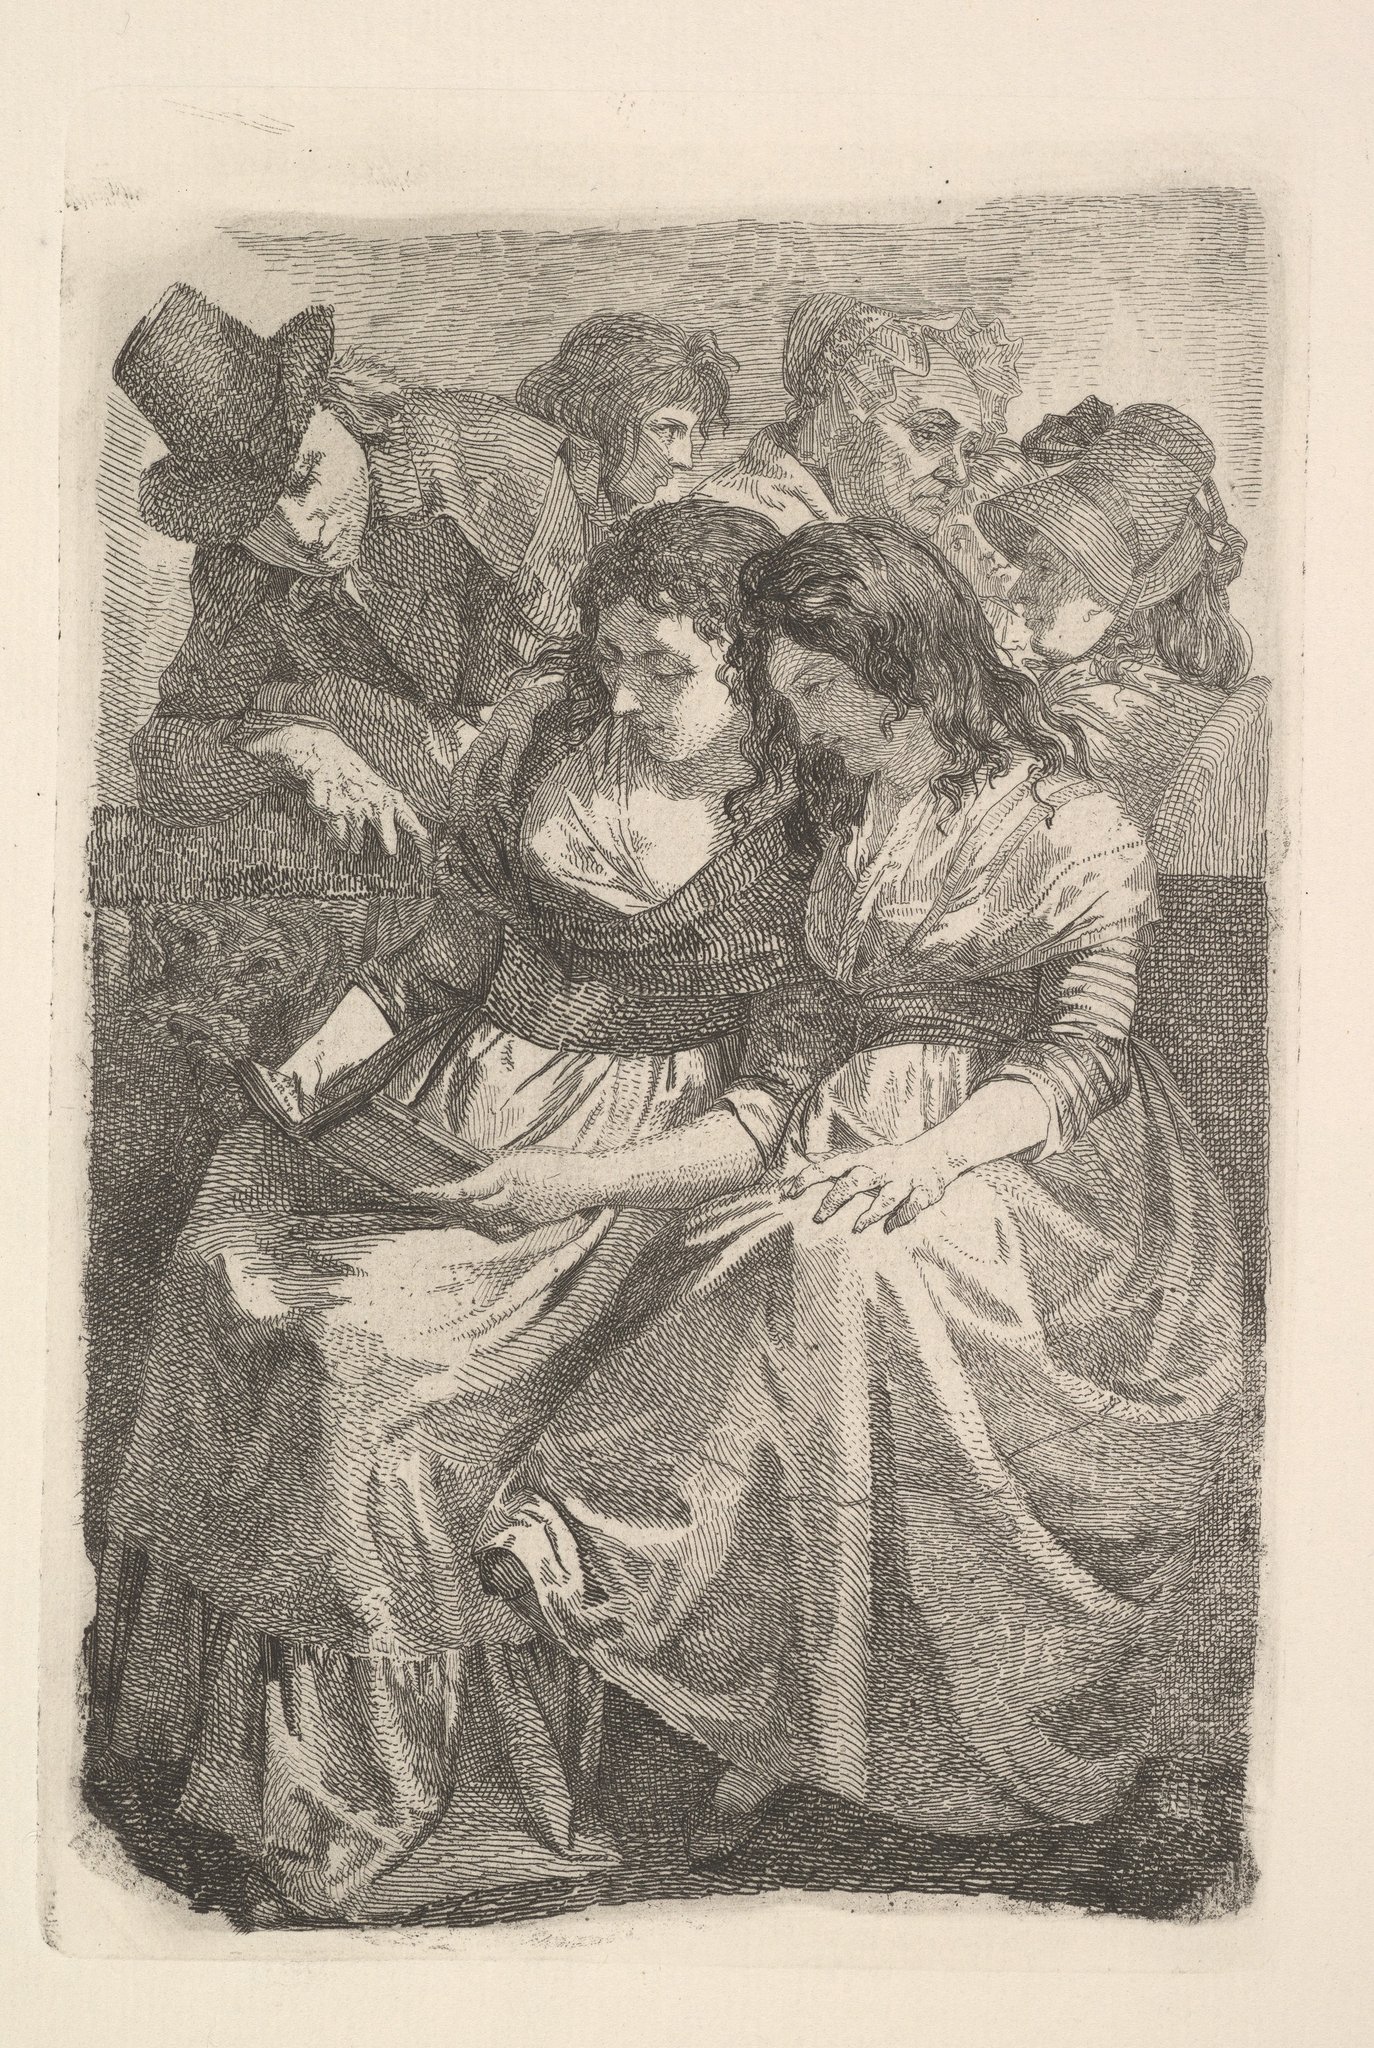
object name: print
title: Schadow and His Family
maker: johann gottfried schadow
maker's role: artist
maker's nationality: german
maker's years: 1764-1850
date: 1925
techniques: etching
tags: men,women,family